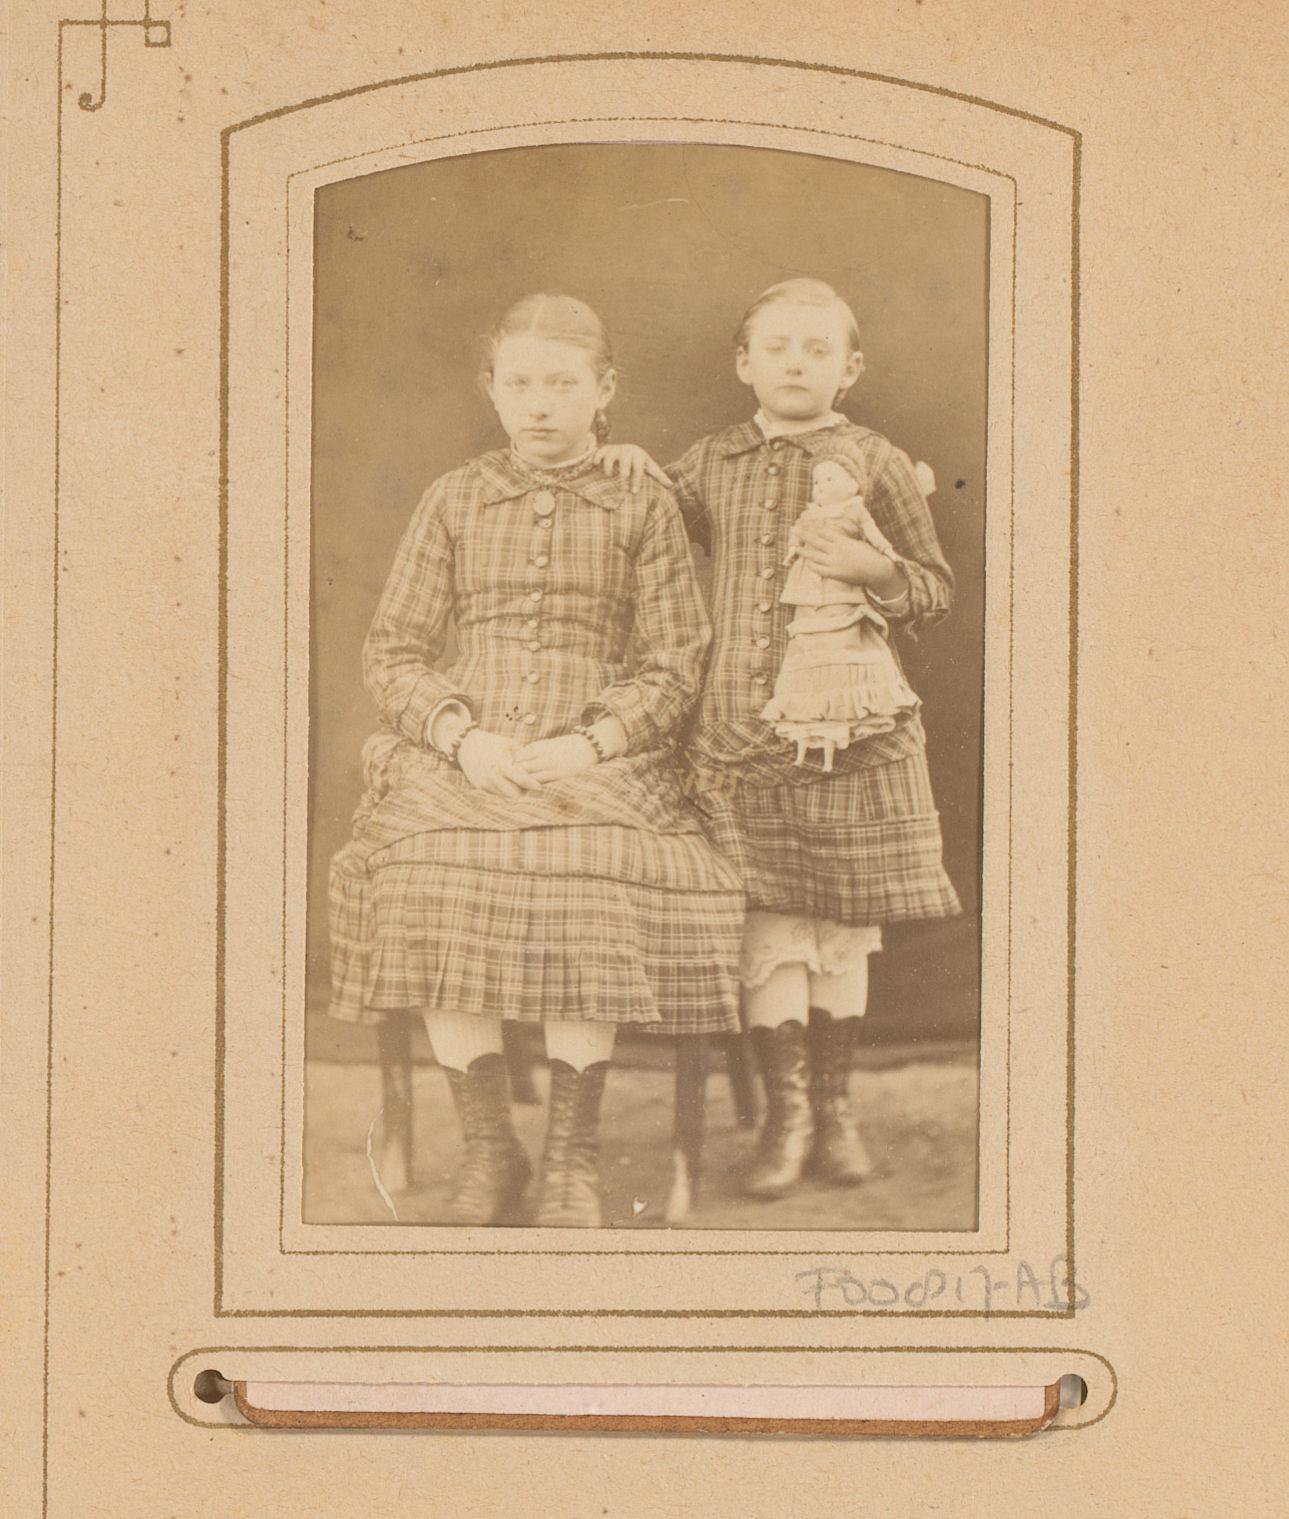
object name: album leaf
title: Portret van twee meisjes met pop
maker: Anonymous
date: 1860-1890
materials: cardboard, photographic support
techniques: albumen print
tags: girl (child between toddler and youth), (playing with) dolls